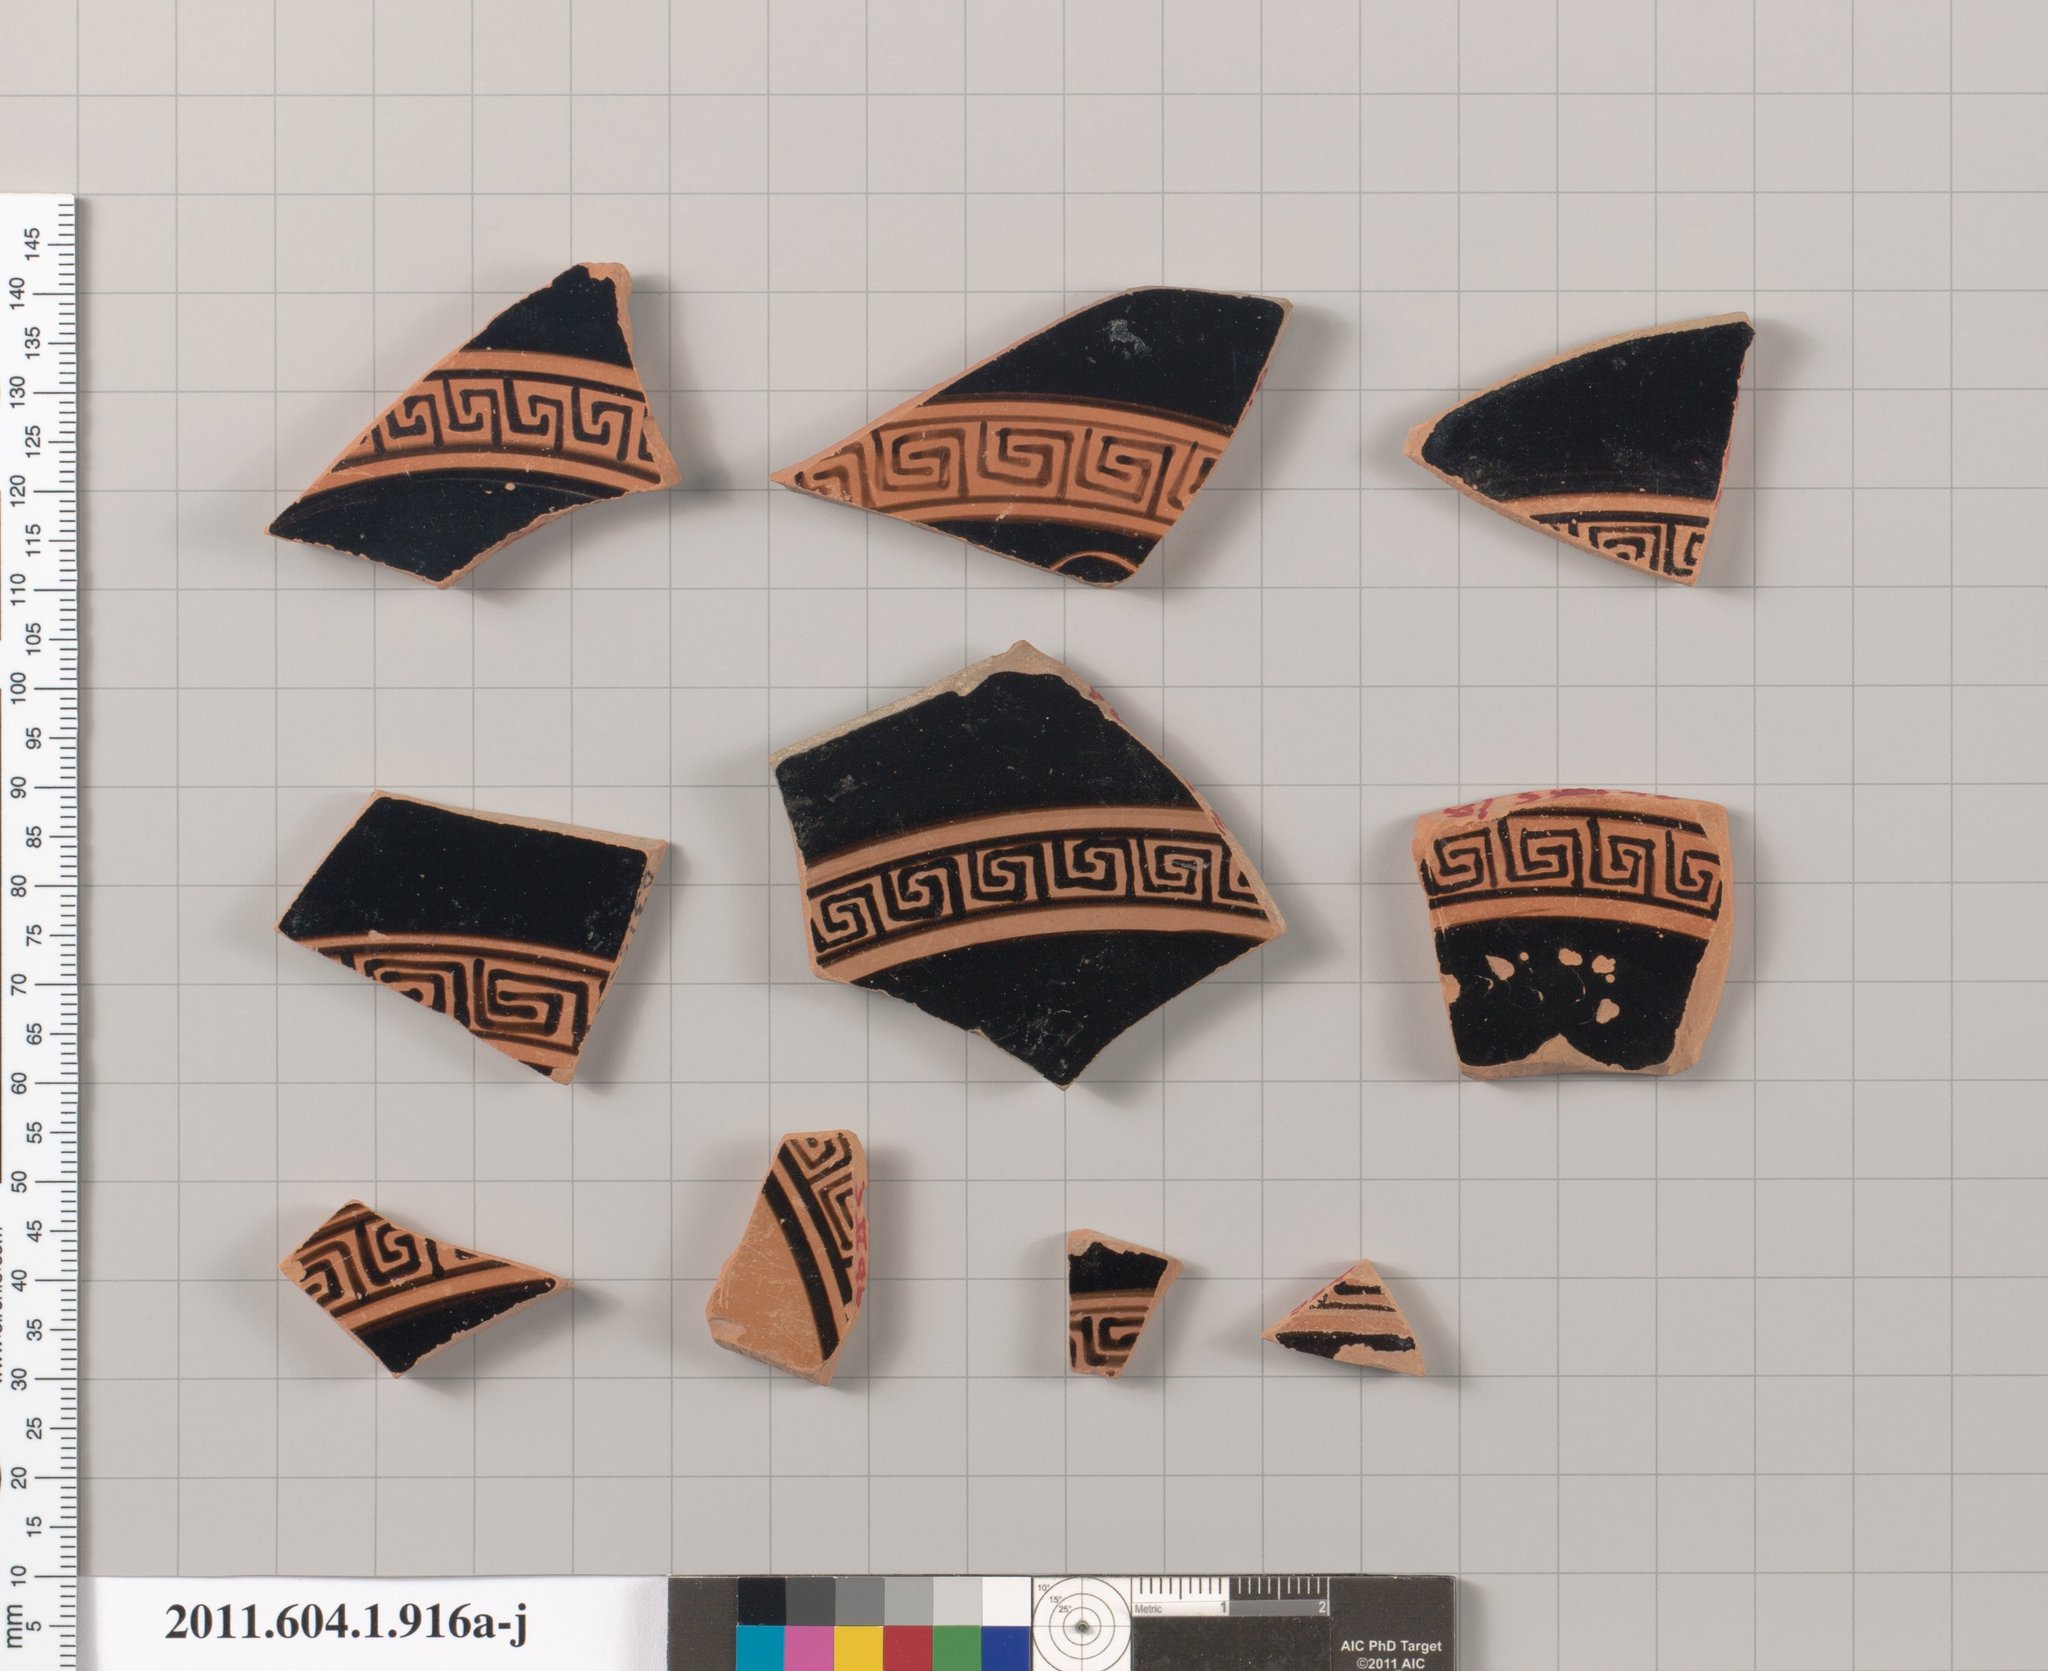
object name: kylix fragment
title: Terracotta fragments of kylikes (drinking cups)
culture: greek, attic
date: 500-401 BCE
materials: terracotta